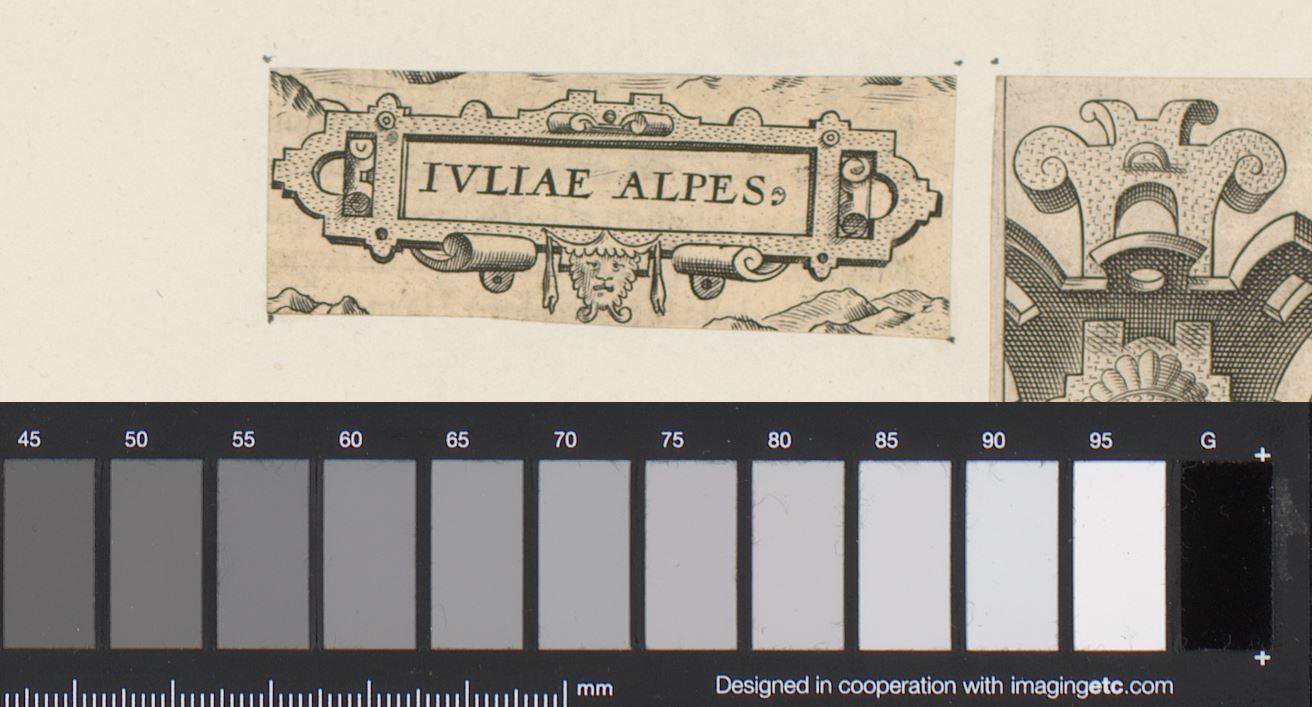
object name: print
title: Theatrum Orbis Terrarum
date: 1572-1575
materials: paper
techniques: engraving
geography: antwerp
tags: ornament ~ cartouche, mask, mascaron ~ ornament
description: Kleine cartouche met mascaron. De cartouche is een fragment van een kaart van Friuli. De prent maakt deel uit van een album.